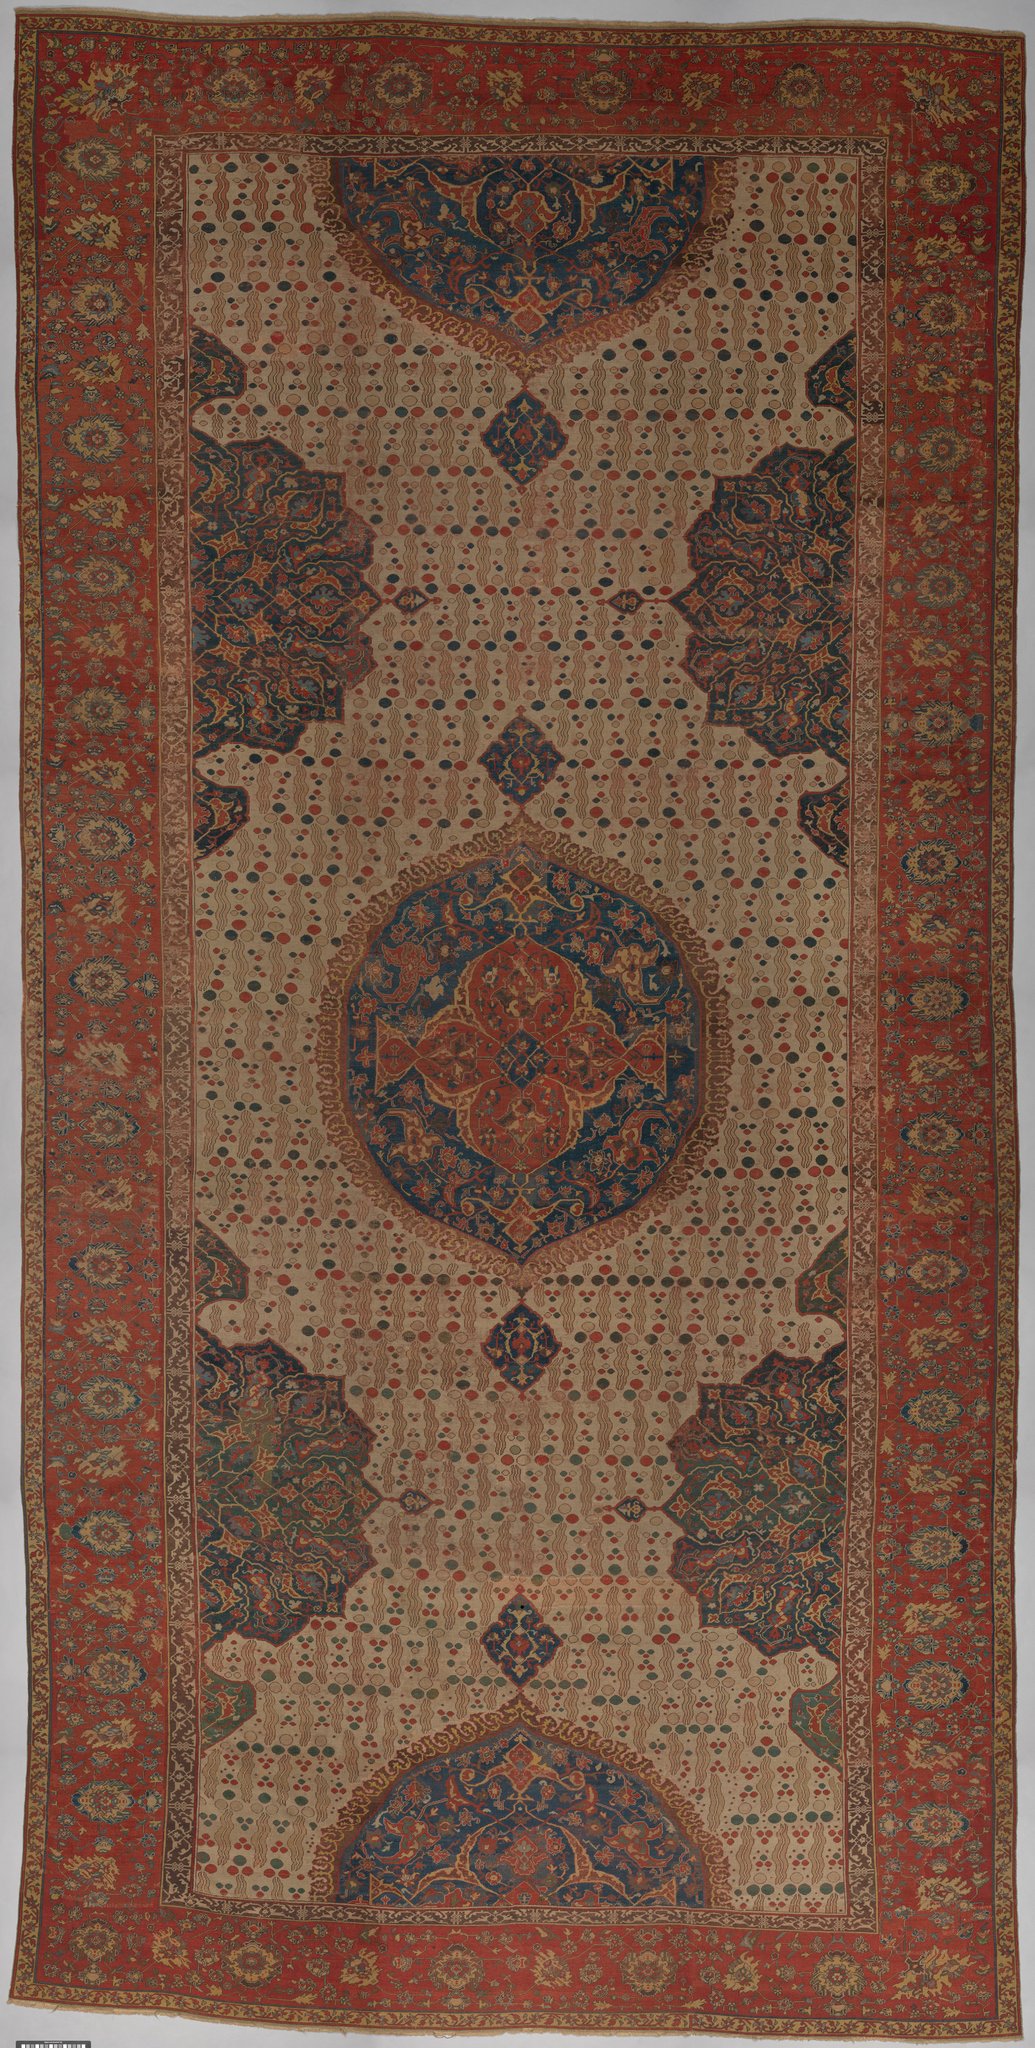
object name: carpet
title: Ushak Medallion Carpet on White Ground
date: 1601-1650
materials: wool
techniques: pile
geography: turkey